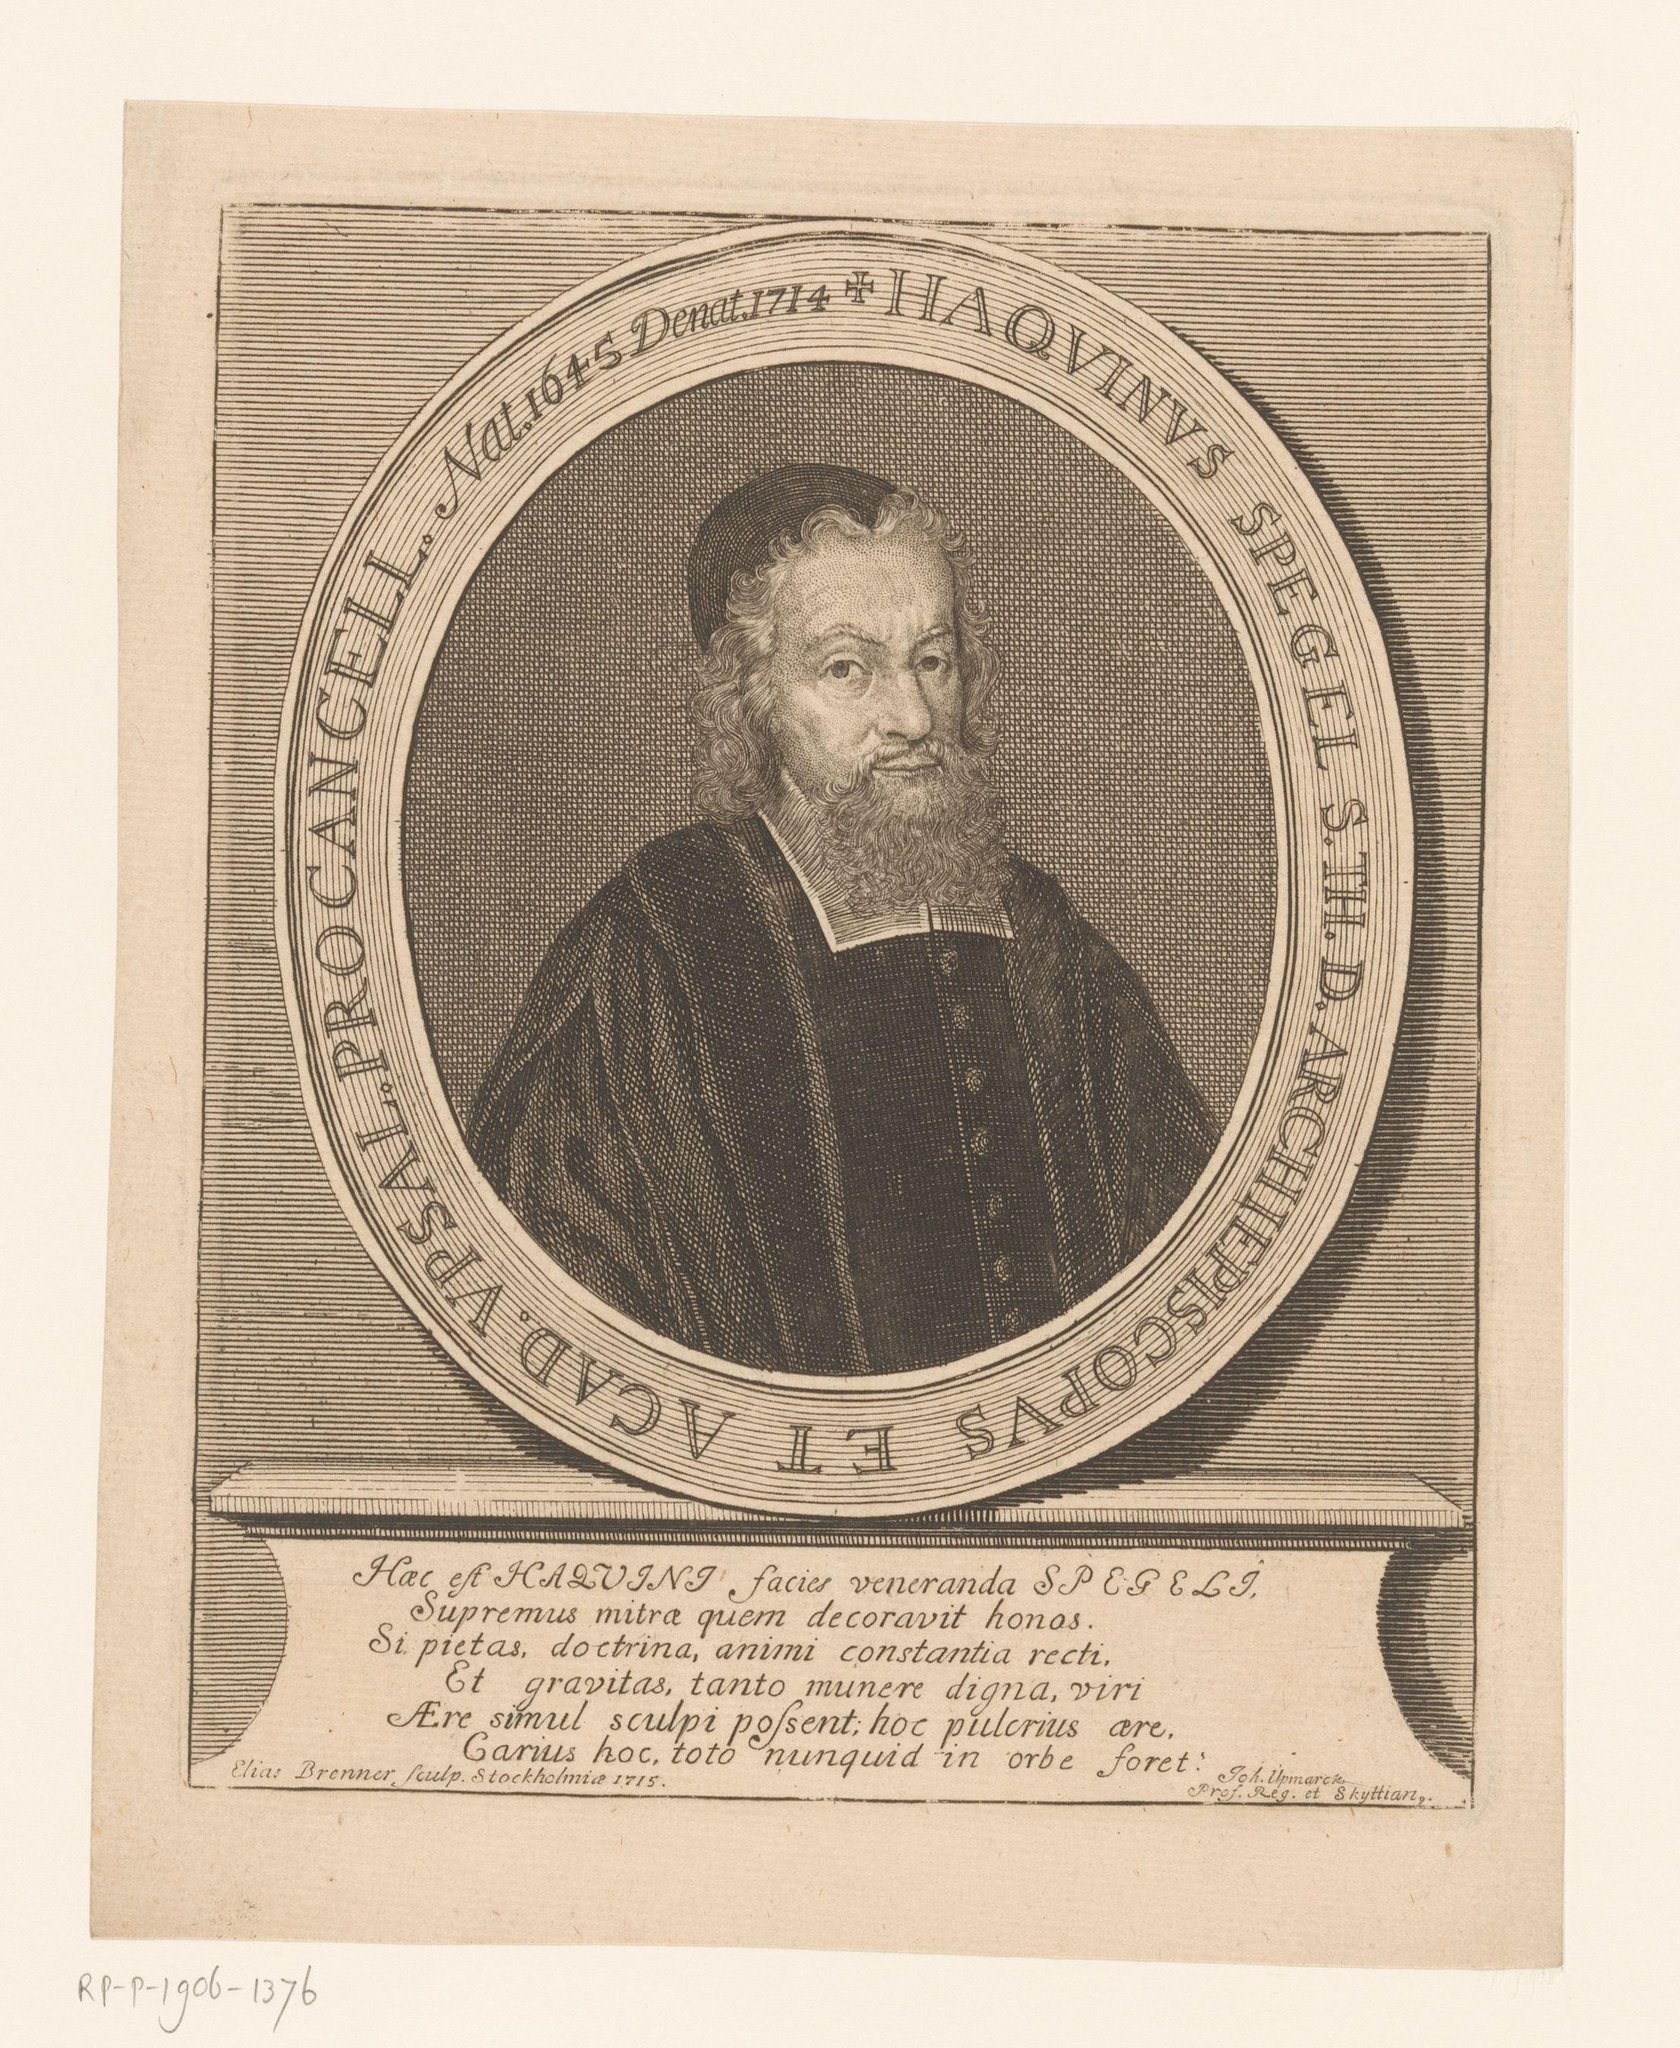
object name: print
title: Portret van Haquin Spegel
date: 1715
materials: paper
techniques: engraving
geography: stockholm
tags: functionaries and dignitaries ~ protestant churches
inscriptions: collector's mark: Lugt 2228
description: Portret van Haquin Spegel (1645-1714), aartsbisschop van Uppsala (1711-1714) en primaat van Zweden. Ten halven lijve, in ovaal, driekwart naar rechts. Met zesregelig Latijns onderschrift.